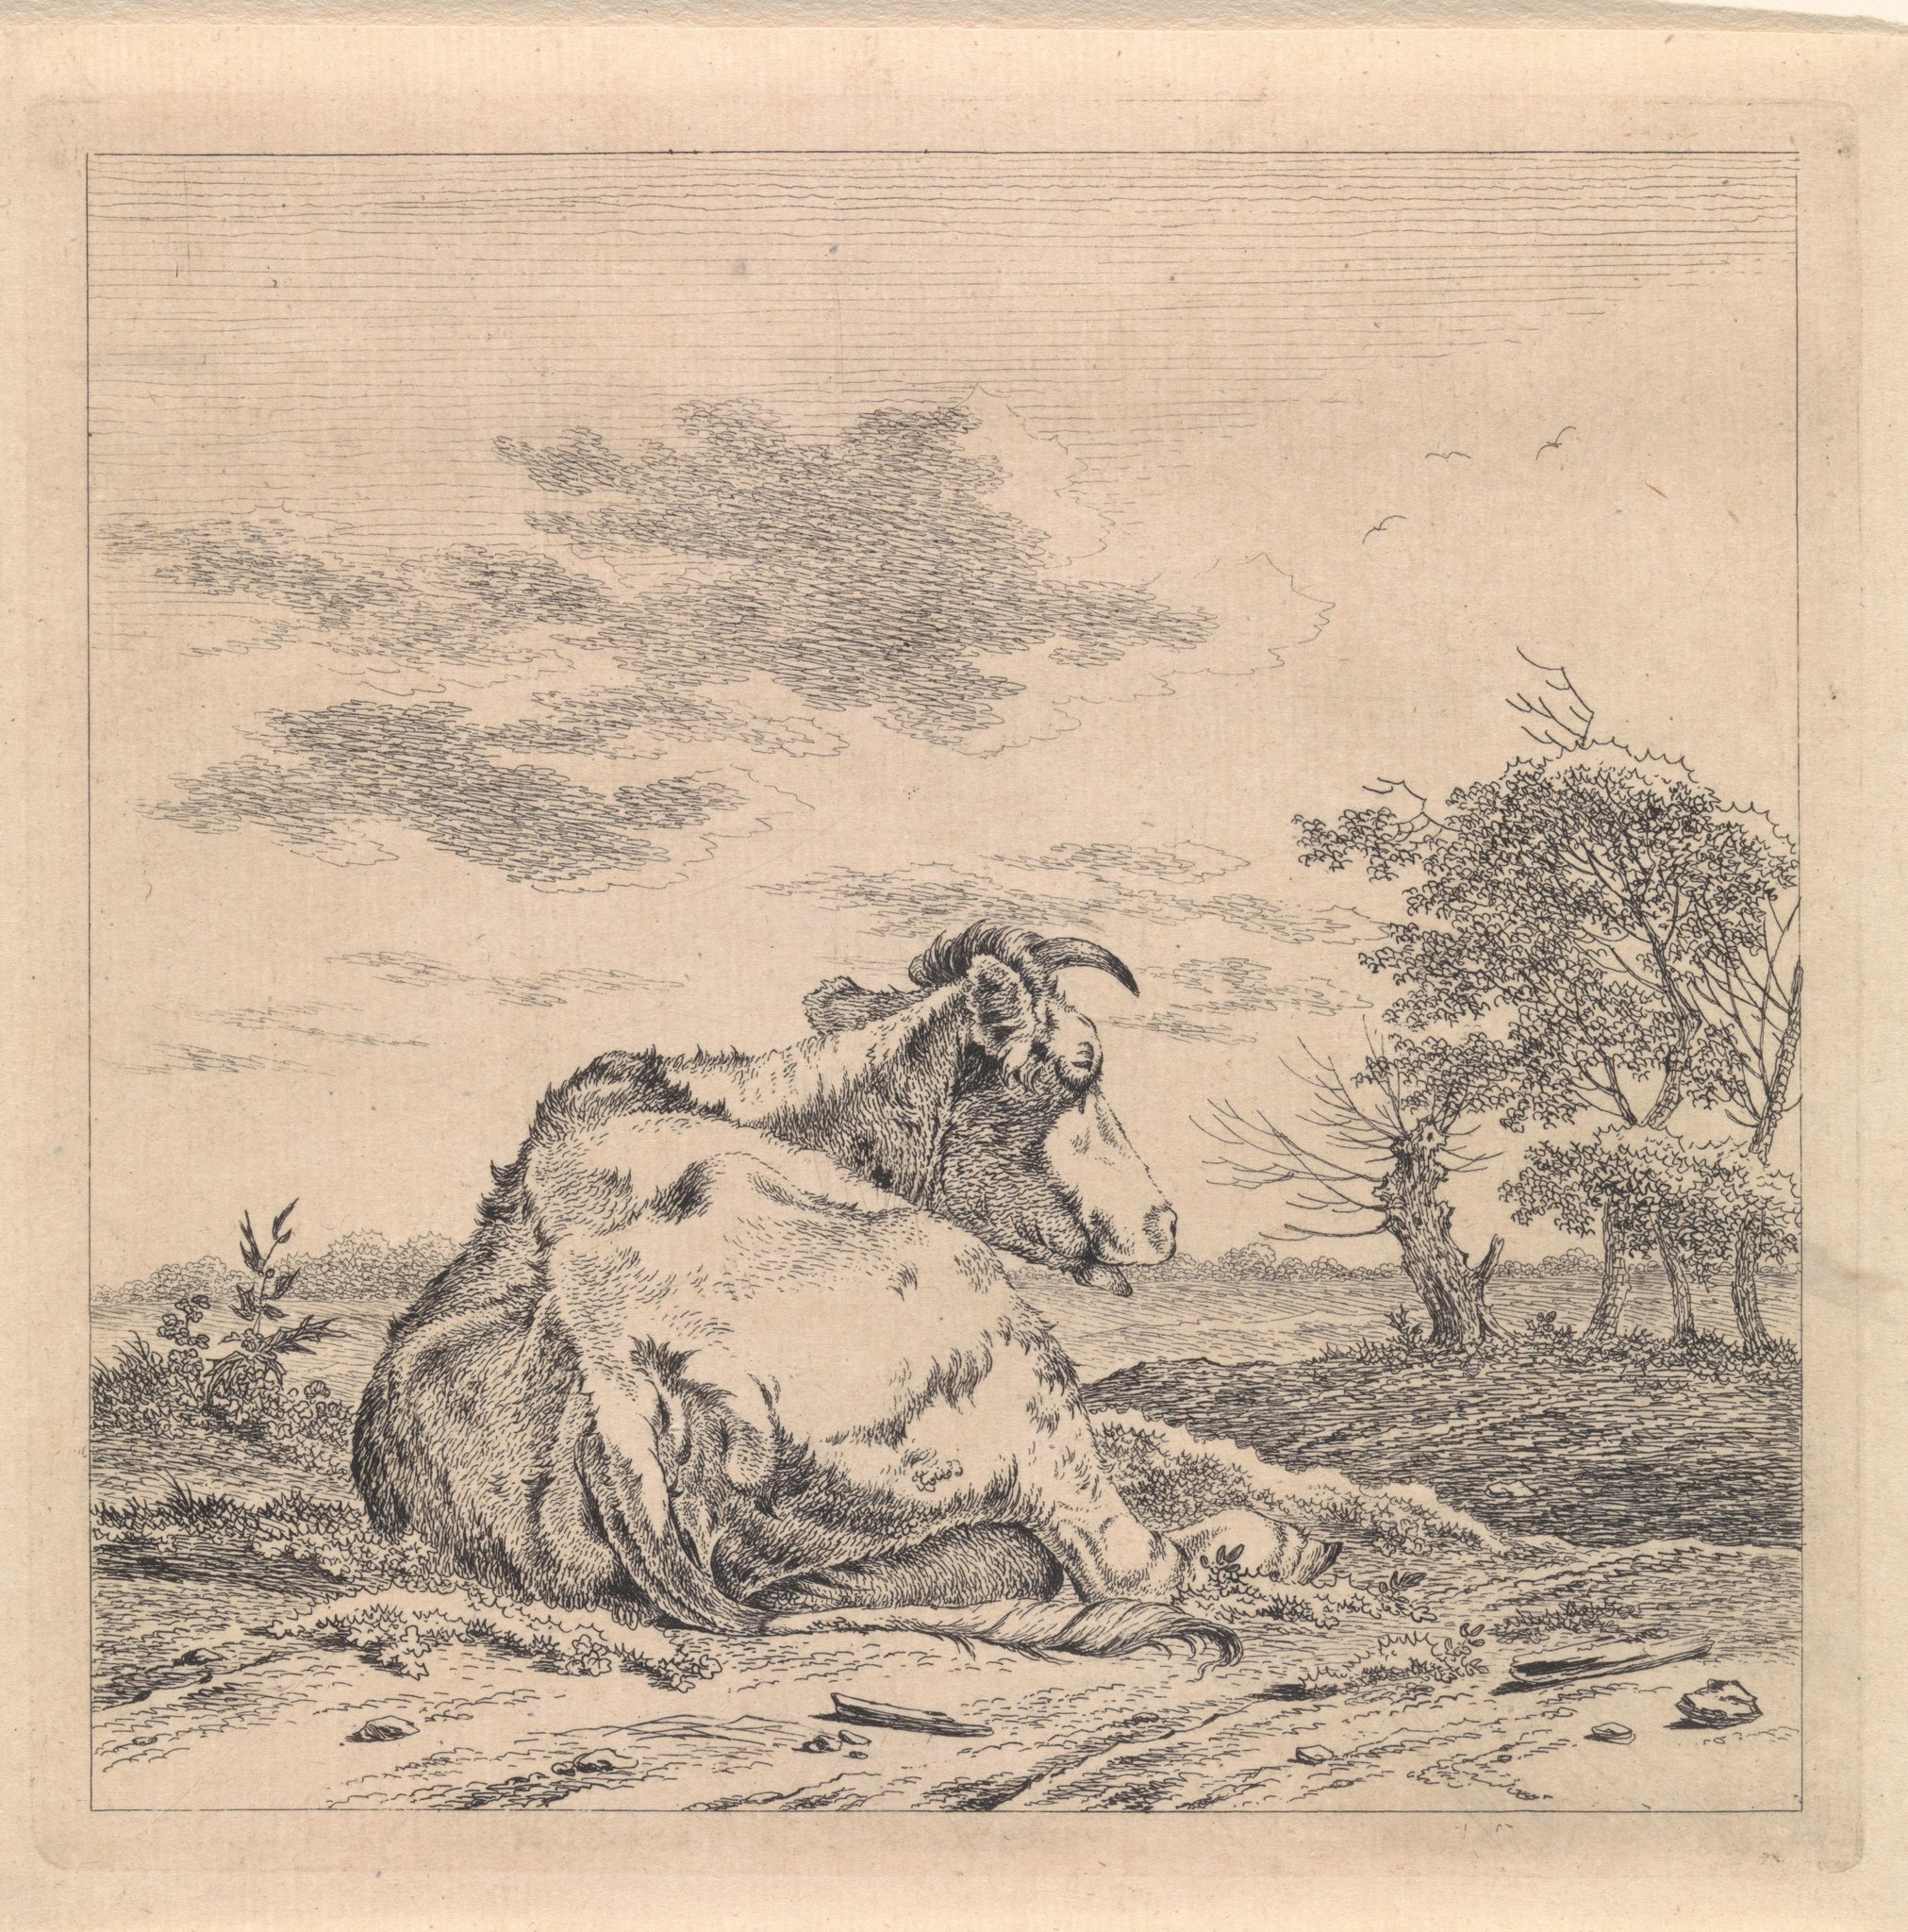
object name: print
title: Landschap met liggende koe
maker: pieter janson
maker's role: draughtsman, print maker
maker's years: 1765-1851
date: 1780-1851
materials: paper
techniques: etching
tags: cow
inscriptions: collector's mark: Lugt 2228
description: Landschap met liggende koe naar rechts, van achter gezien. Op de achtergrond een wilg en drie bomen. Meer bewerkt dan vorige staten.